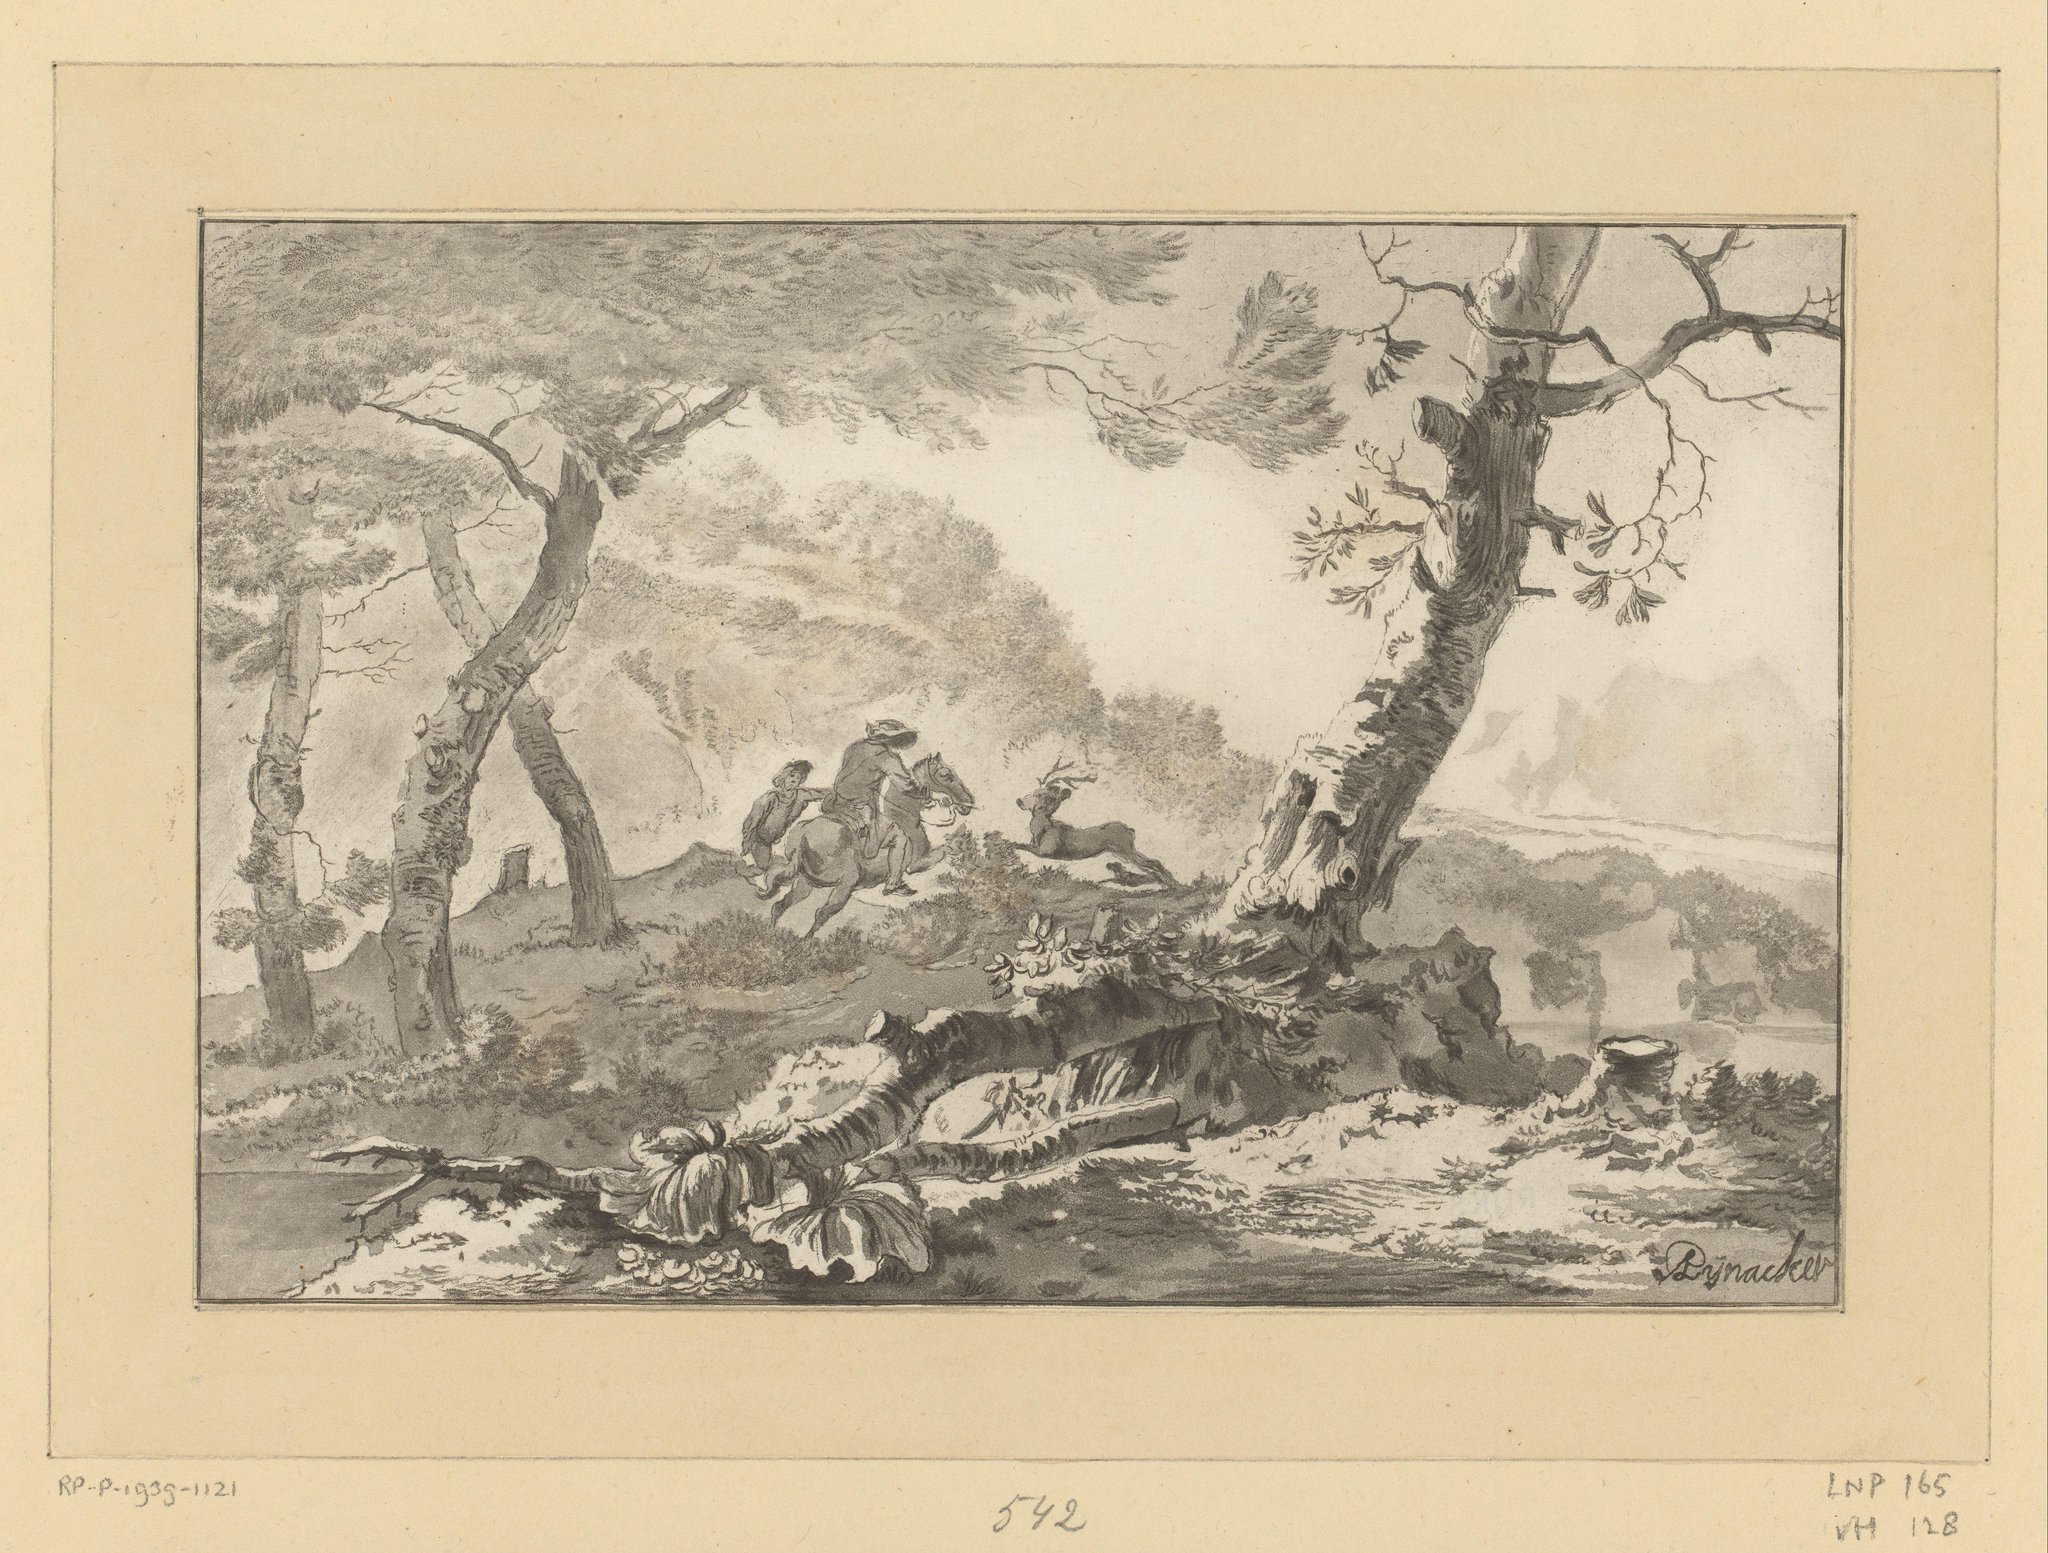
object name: print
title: Landschap met hertenjacht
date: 1741-1803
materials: paper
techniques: printmaking, roulette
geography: amsterdam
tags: stag-hunting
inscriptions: collector's mark: ‘RIJKS / MUSM’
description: Cornelis Brouwer heeft in samenwerking met C.S. Roos een aantal prenttekeningen uitgegeven welke op het verso het signatuur C.Brouwer fecit en C.S. Roos excudit Amst. dragen. De prent werd opgenomen in: Collection d'imitations de dessins d'après les principaux maîtres hollandais et flamands, Londen, C. Josi, 1821.